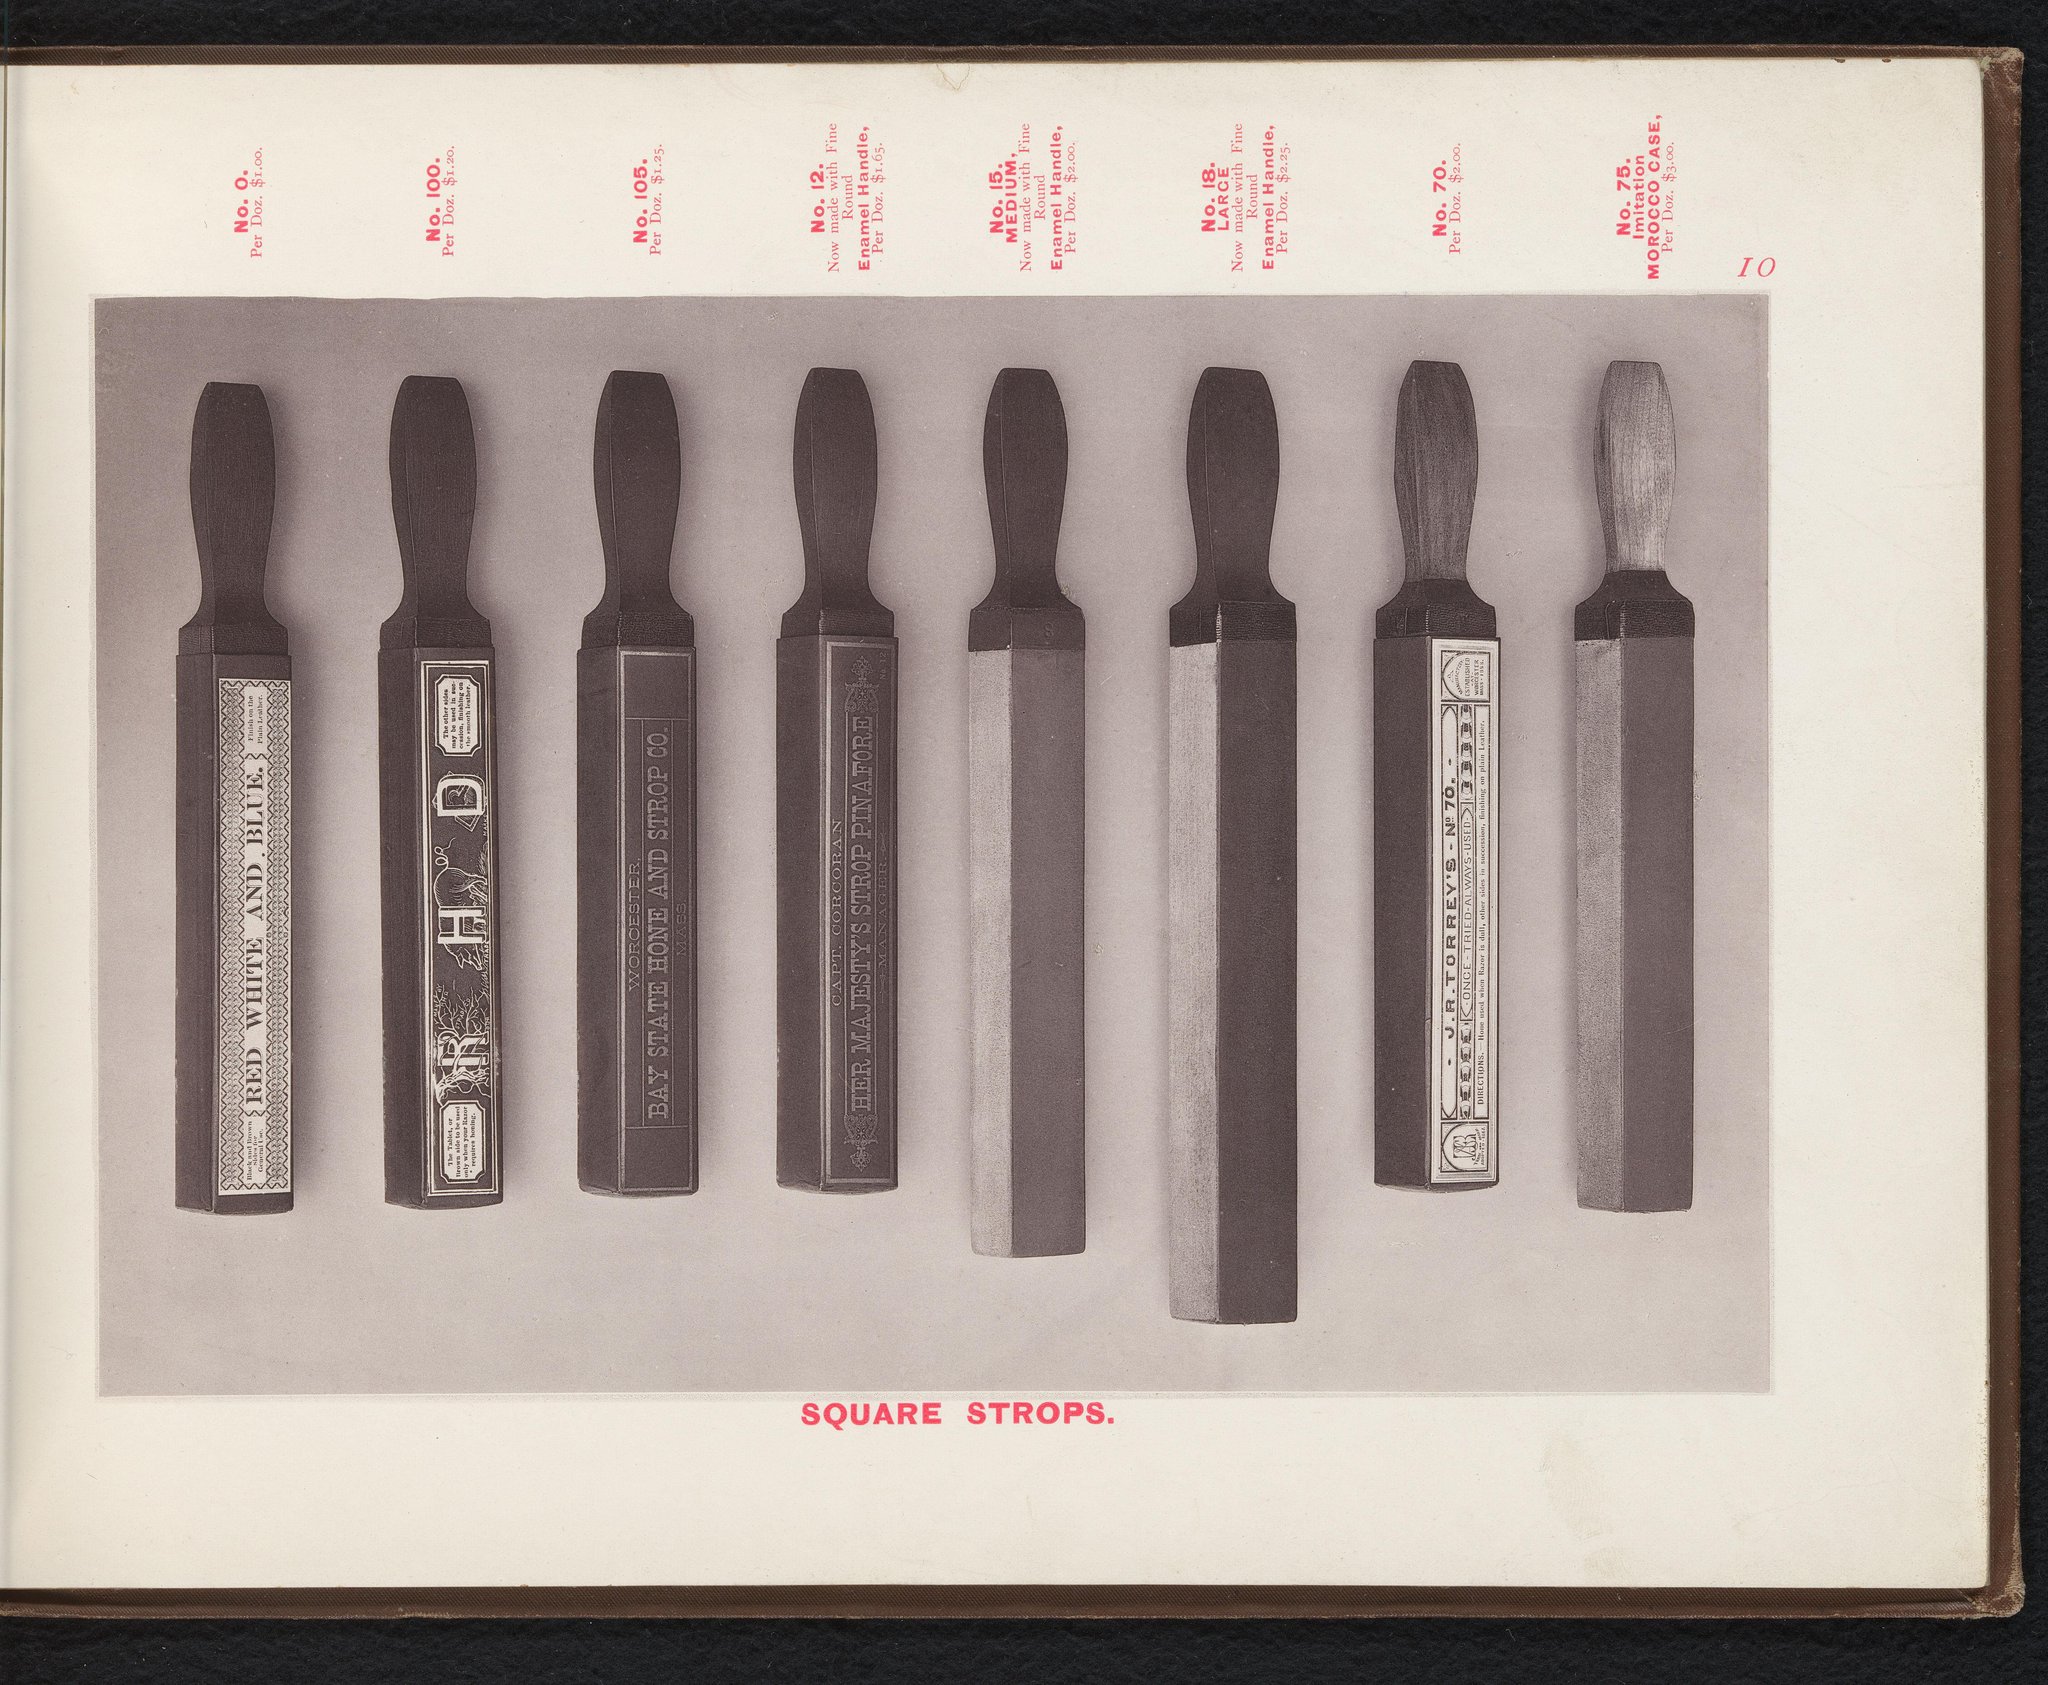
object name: photomechanical print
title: Square strops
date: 1876-1881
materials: paper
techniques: photograph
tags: care of the body, hygiene, razor